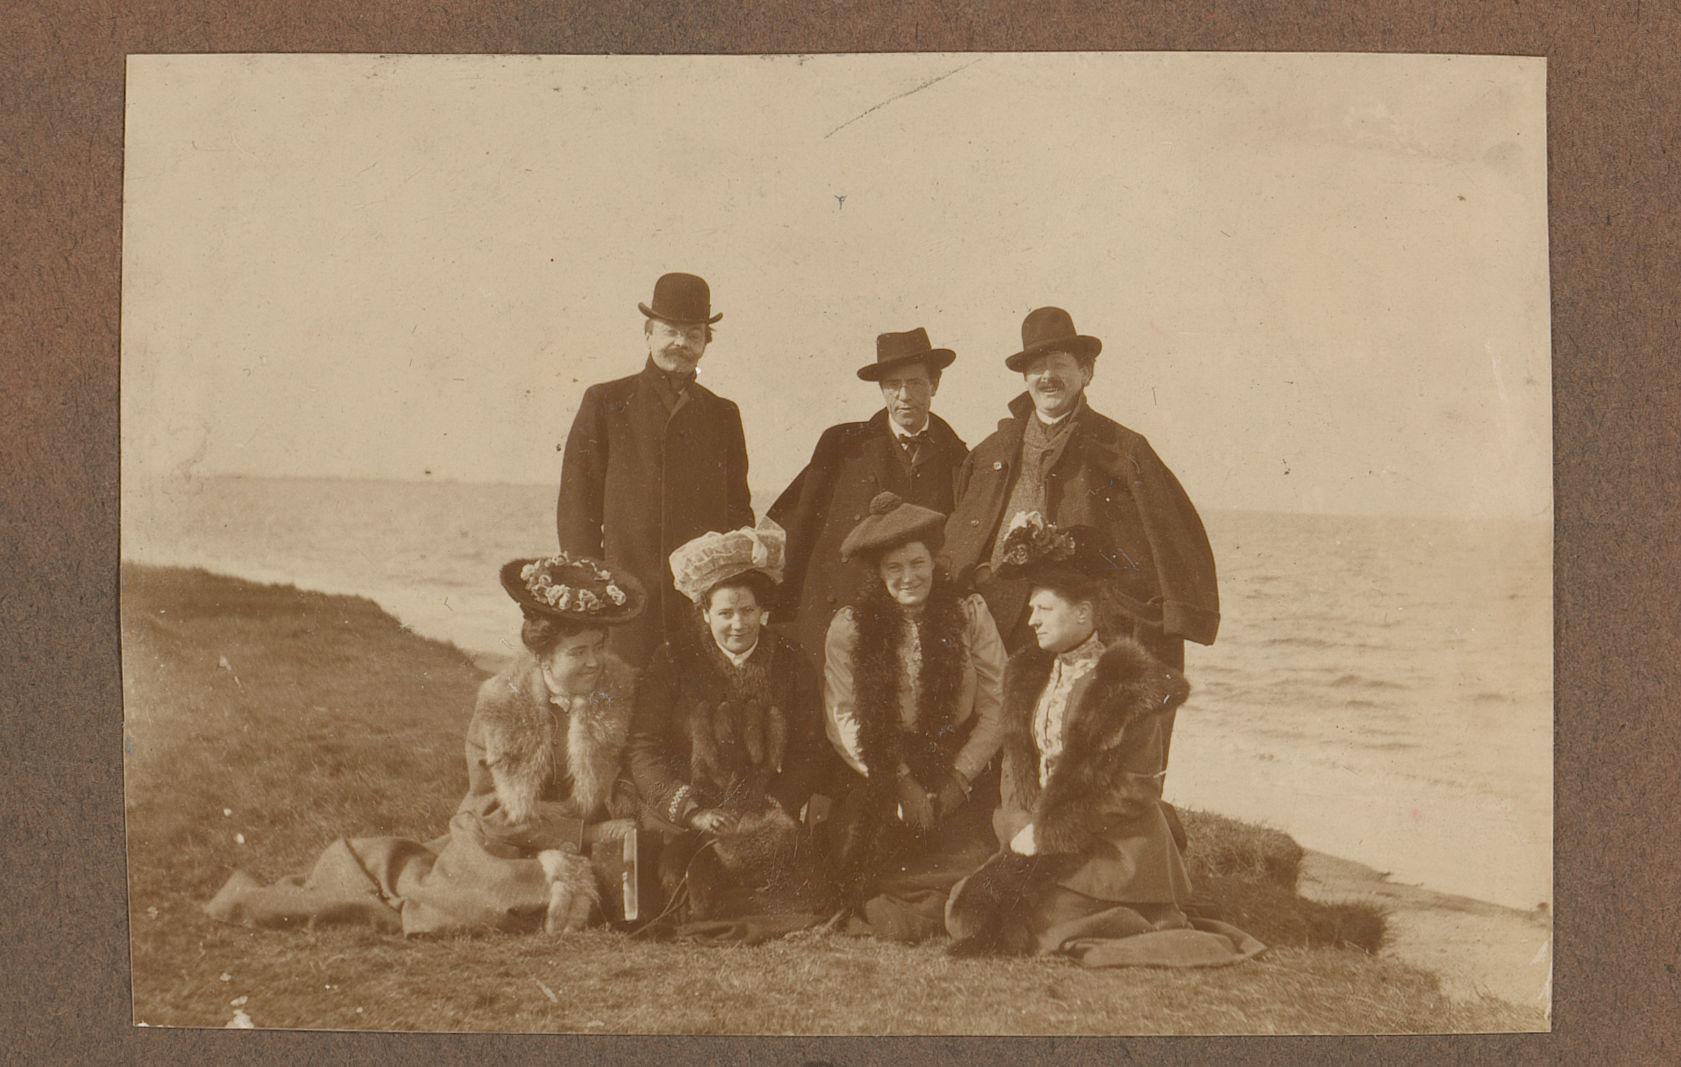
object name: photograph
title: Alphons Diepenbrock, Gustav Mahler en Willem Mengelberg aan het strand met vier vrouwen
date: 1908-1915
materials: photographic support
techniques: photography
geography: netherlands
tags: utrecht, alphons diepenbrock, vienna, gustav mahler, netherlands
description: Foto op bruin albumblad 47 van familiealbum van Alphons Diepenbrock.